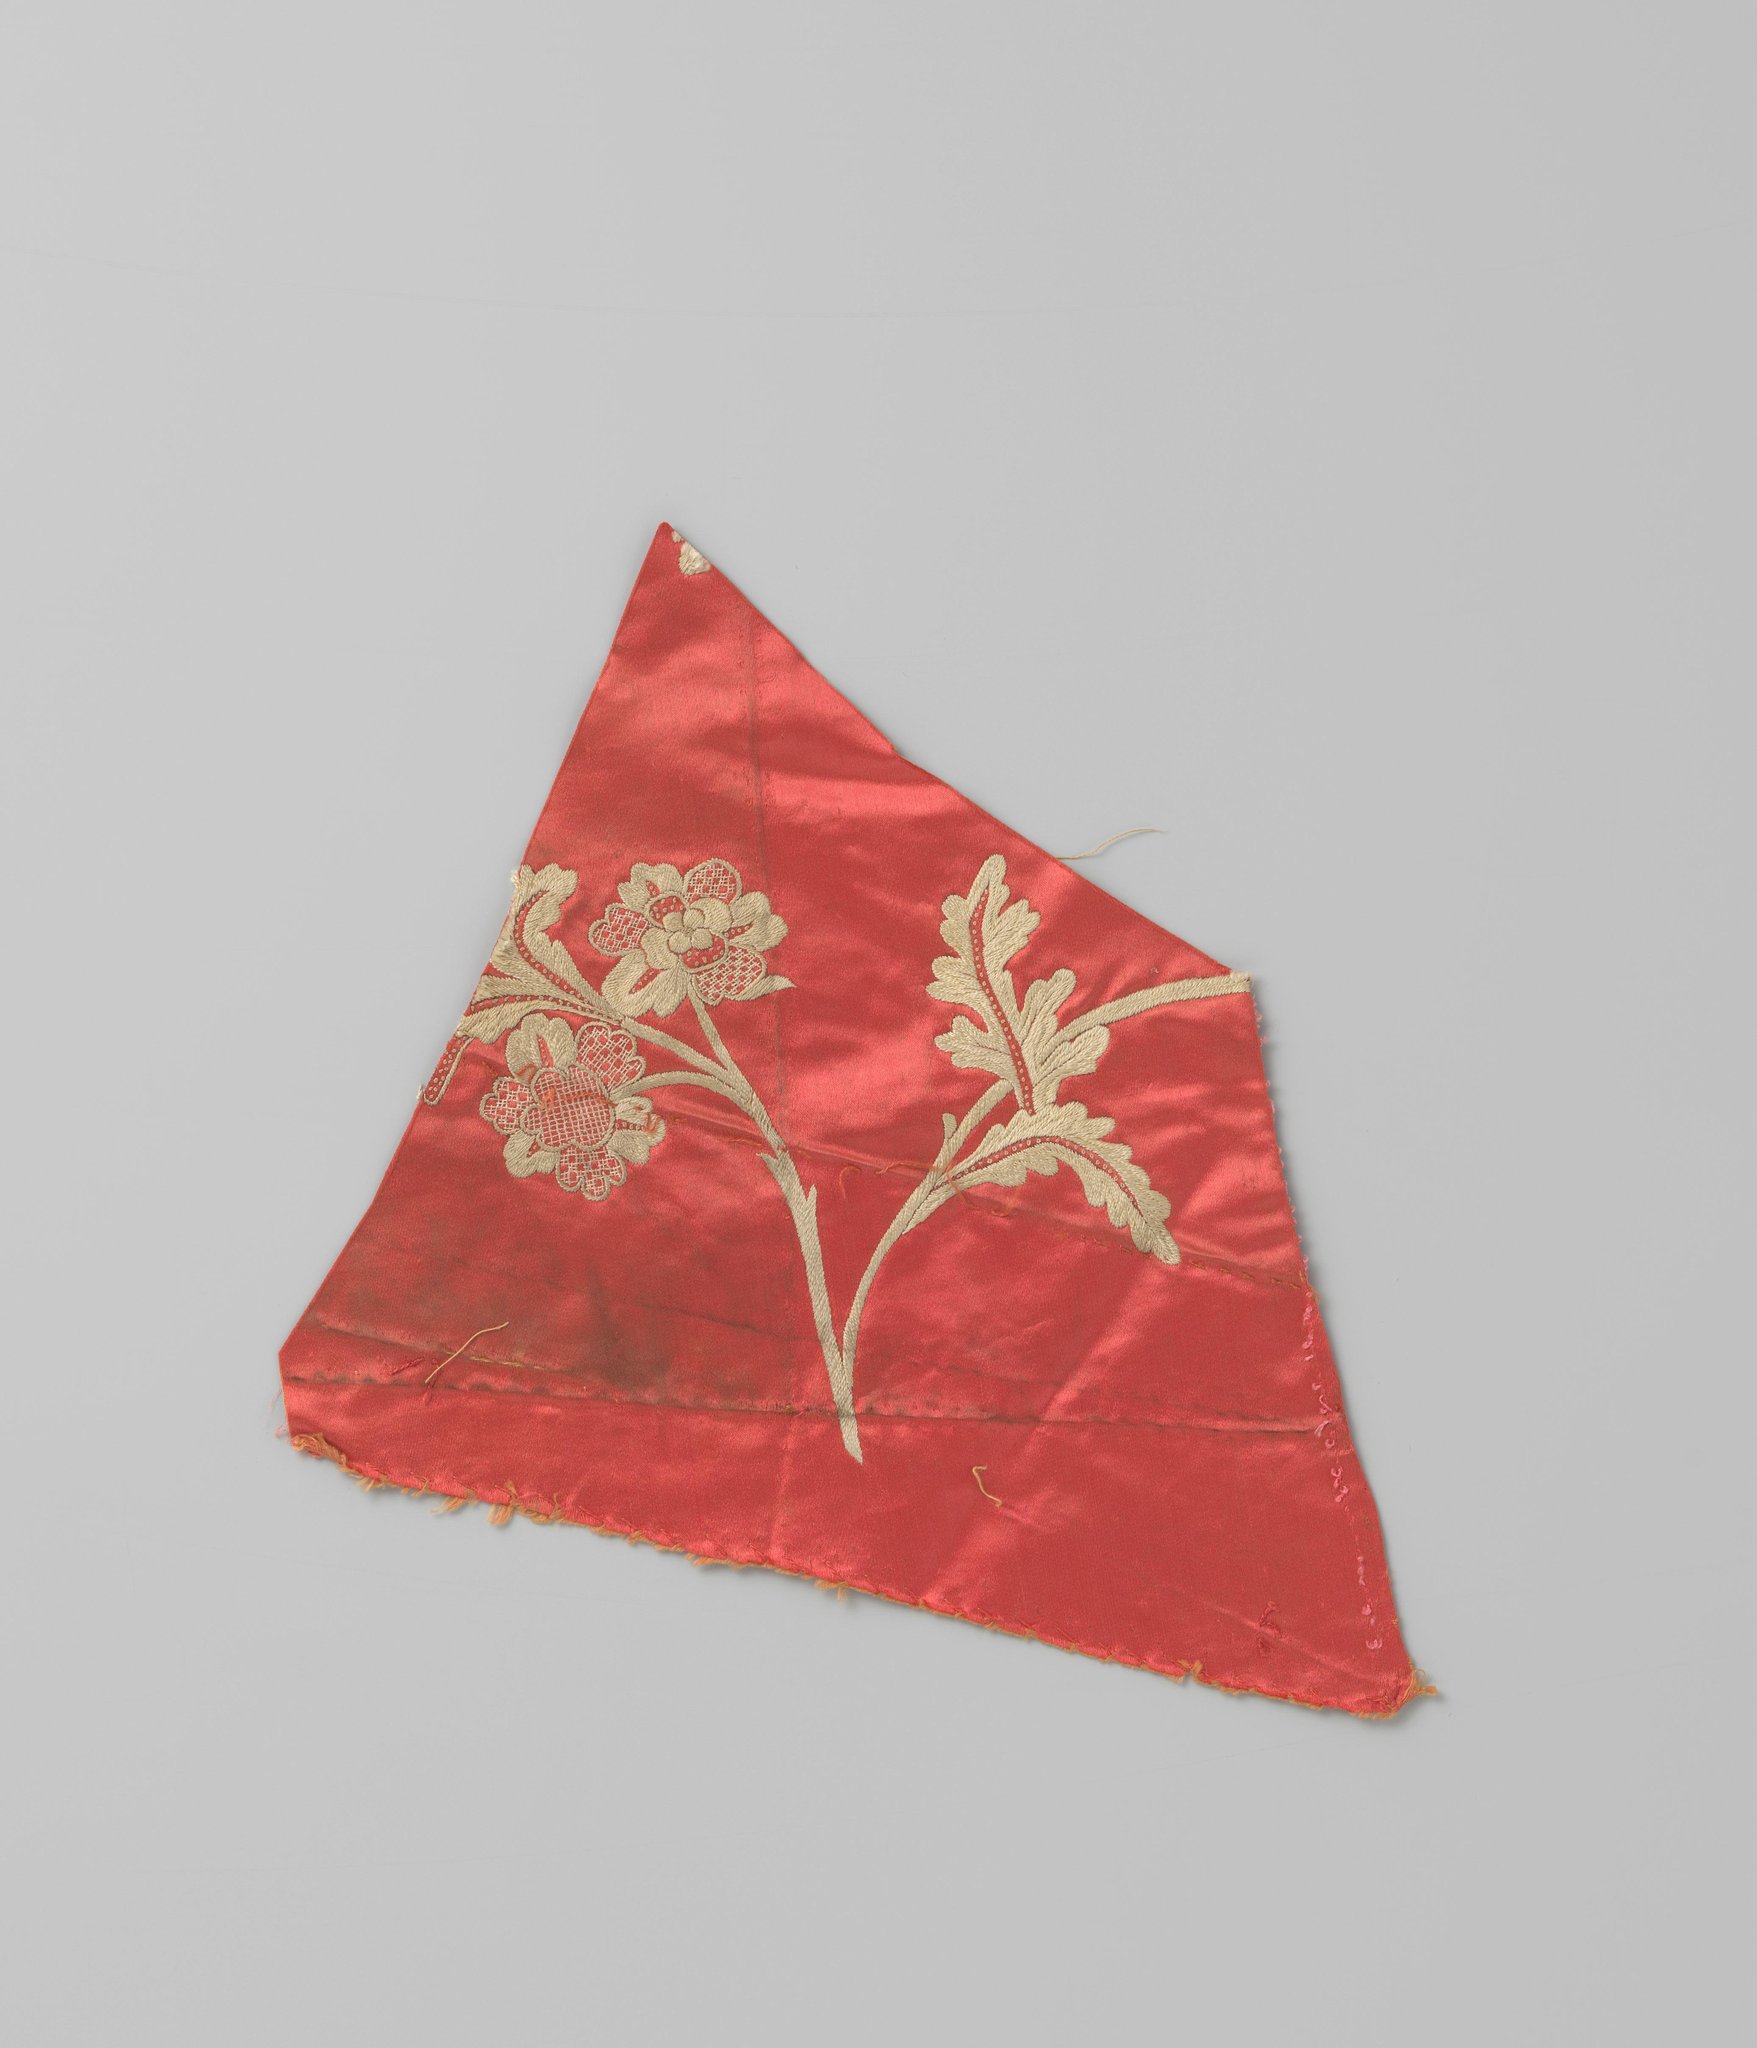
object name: fragment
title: Embroidered Interior Textile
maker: Anonymous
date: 1750-1760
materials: silk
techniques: embroidered, weave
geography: france